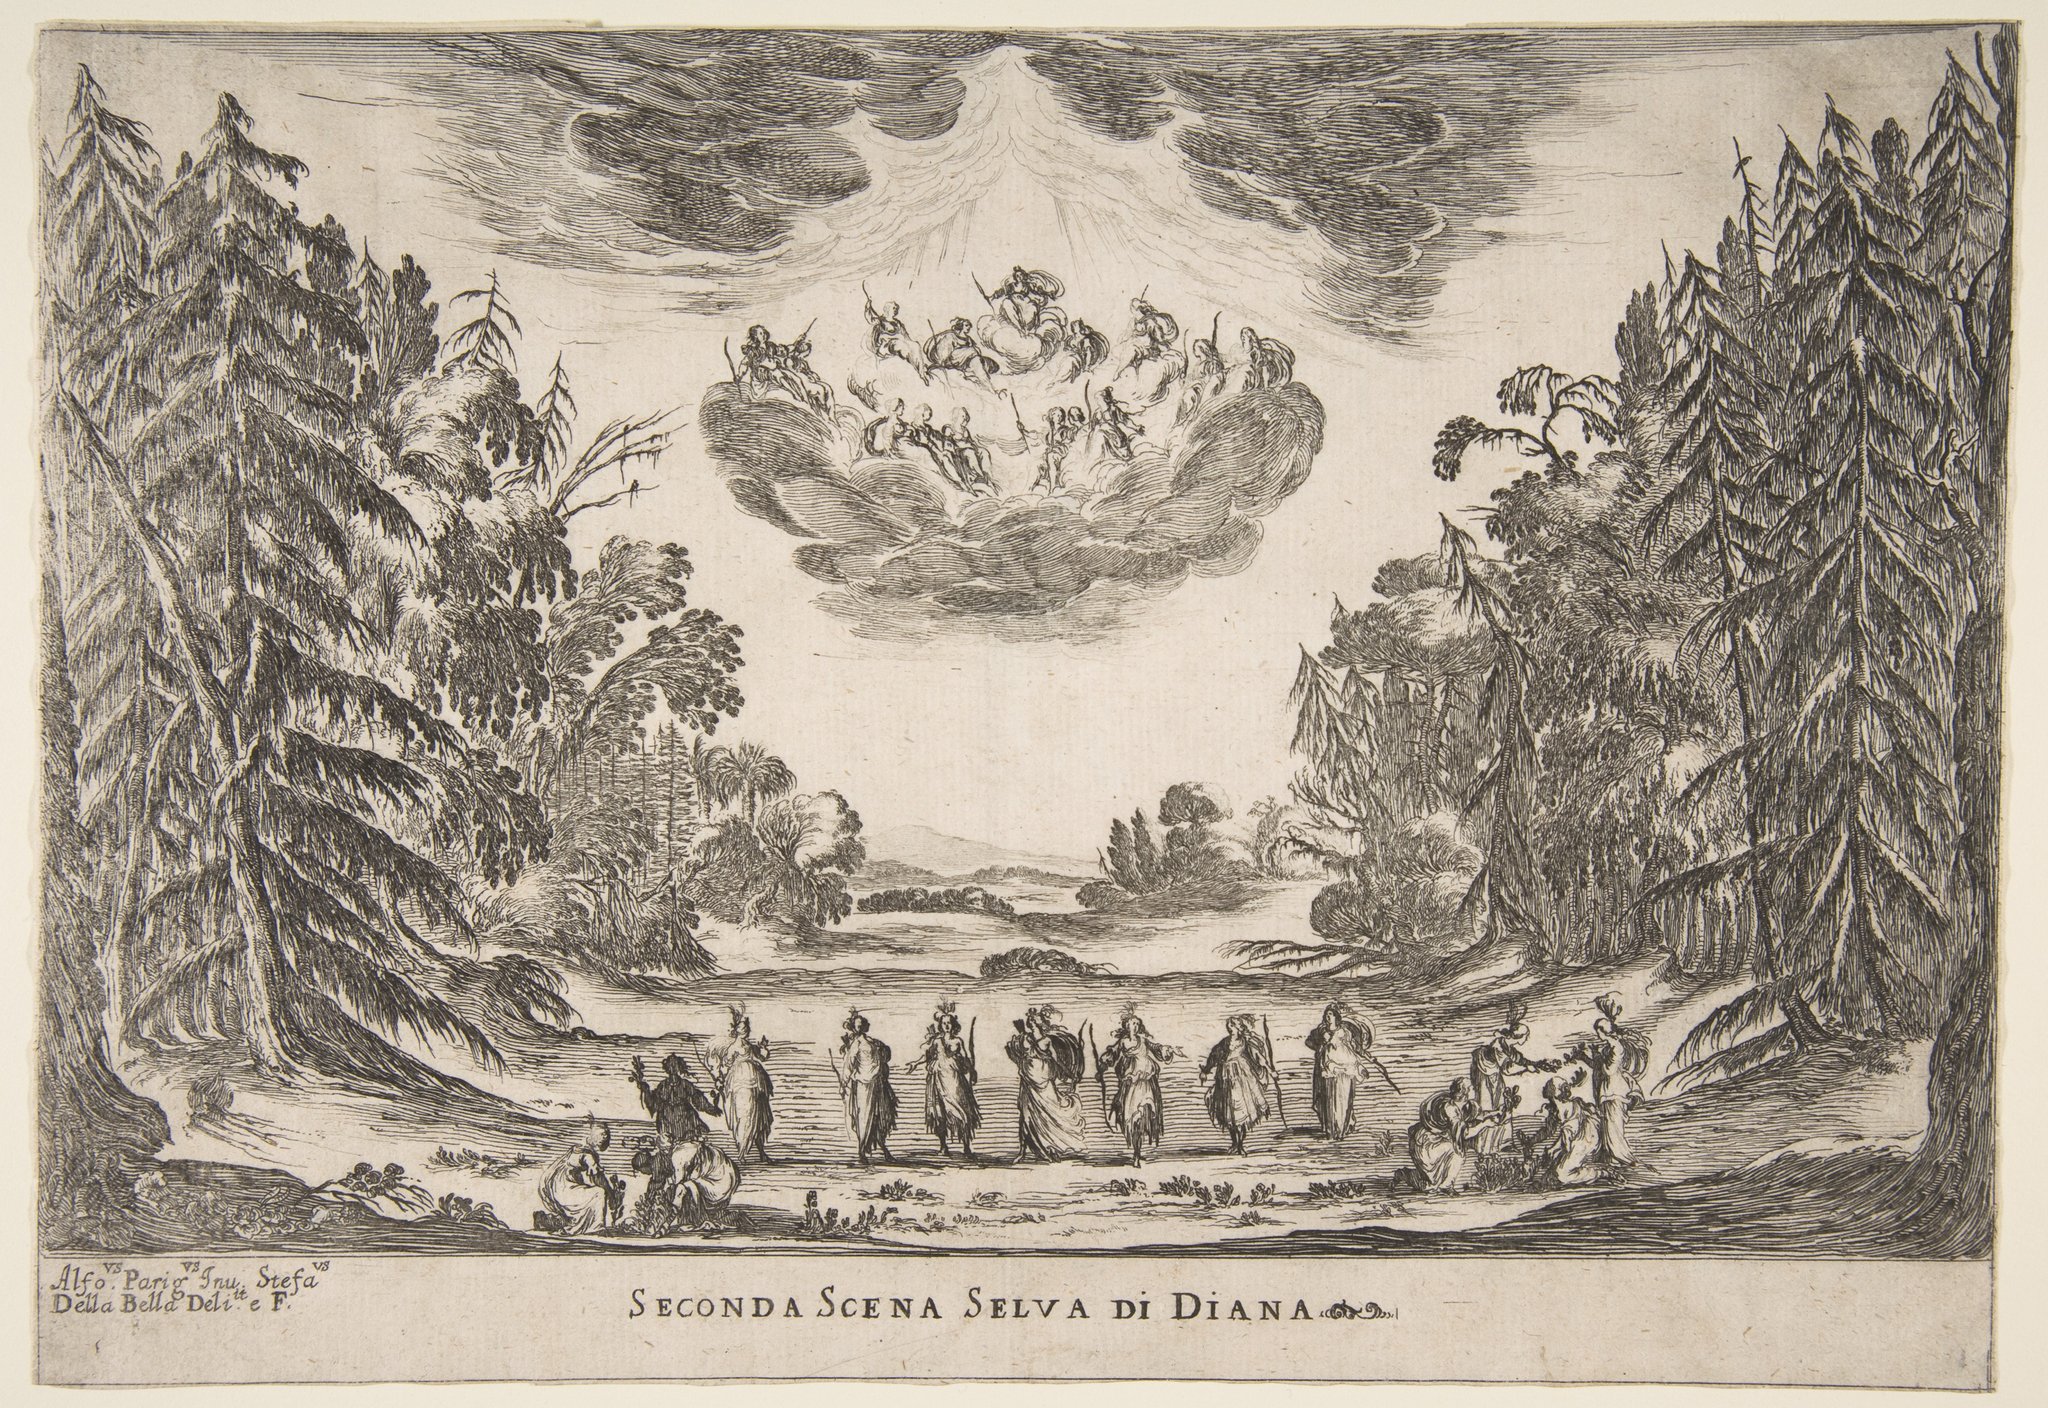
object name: print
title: The Wedding of the Gods: Second Scene, Diana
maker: stefano della bella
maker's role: artist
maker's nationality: italian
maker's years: 1610-1664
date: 1637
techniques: etching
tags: landscapes